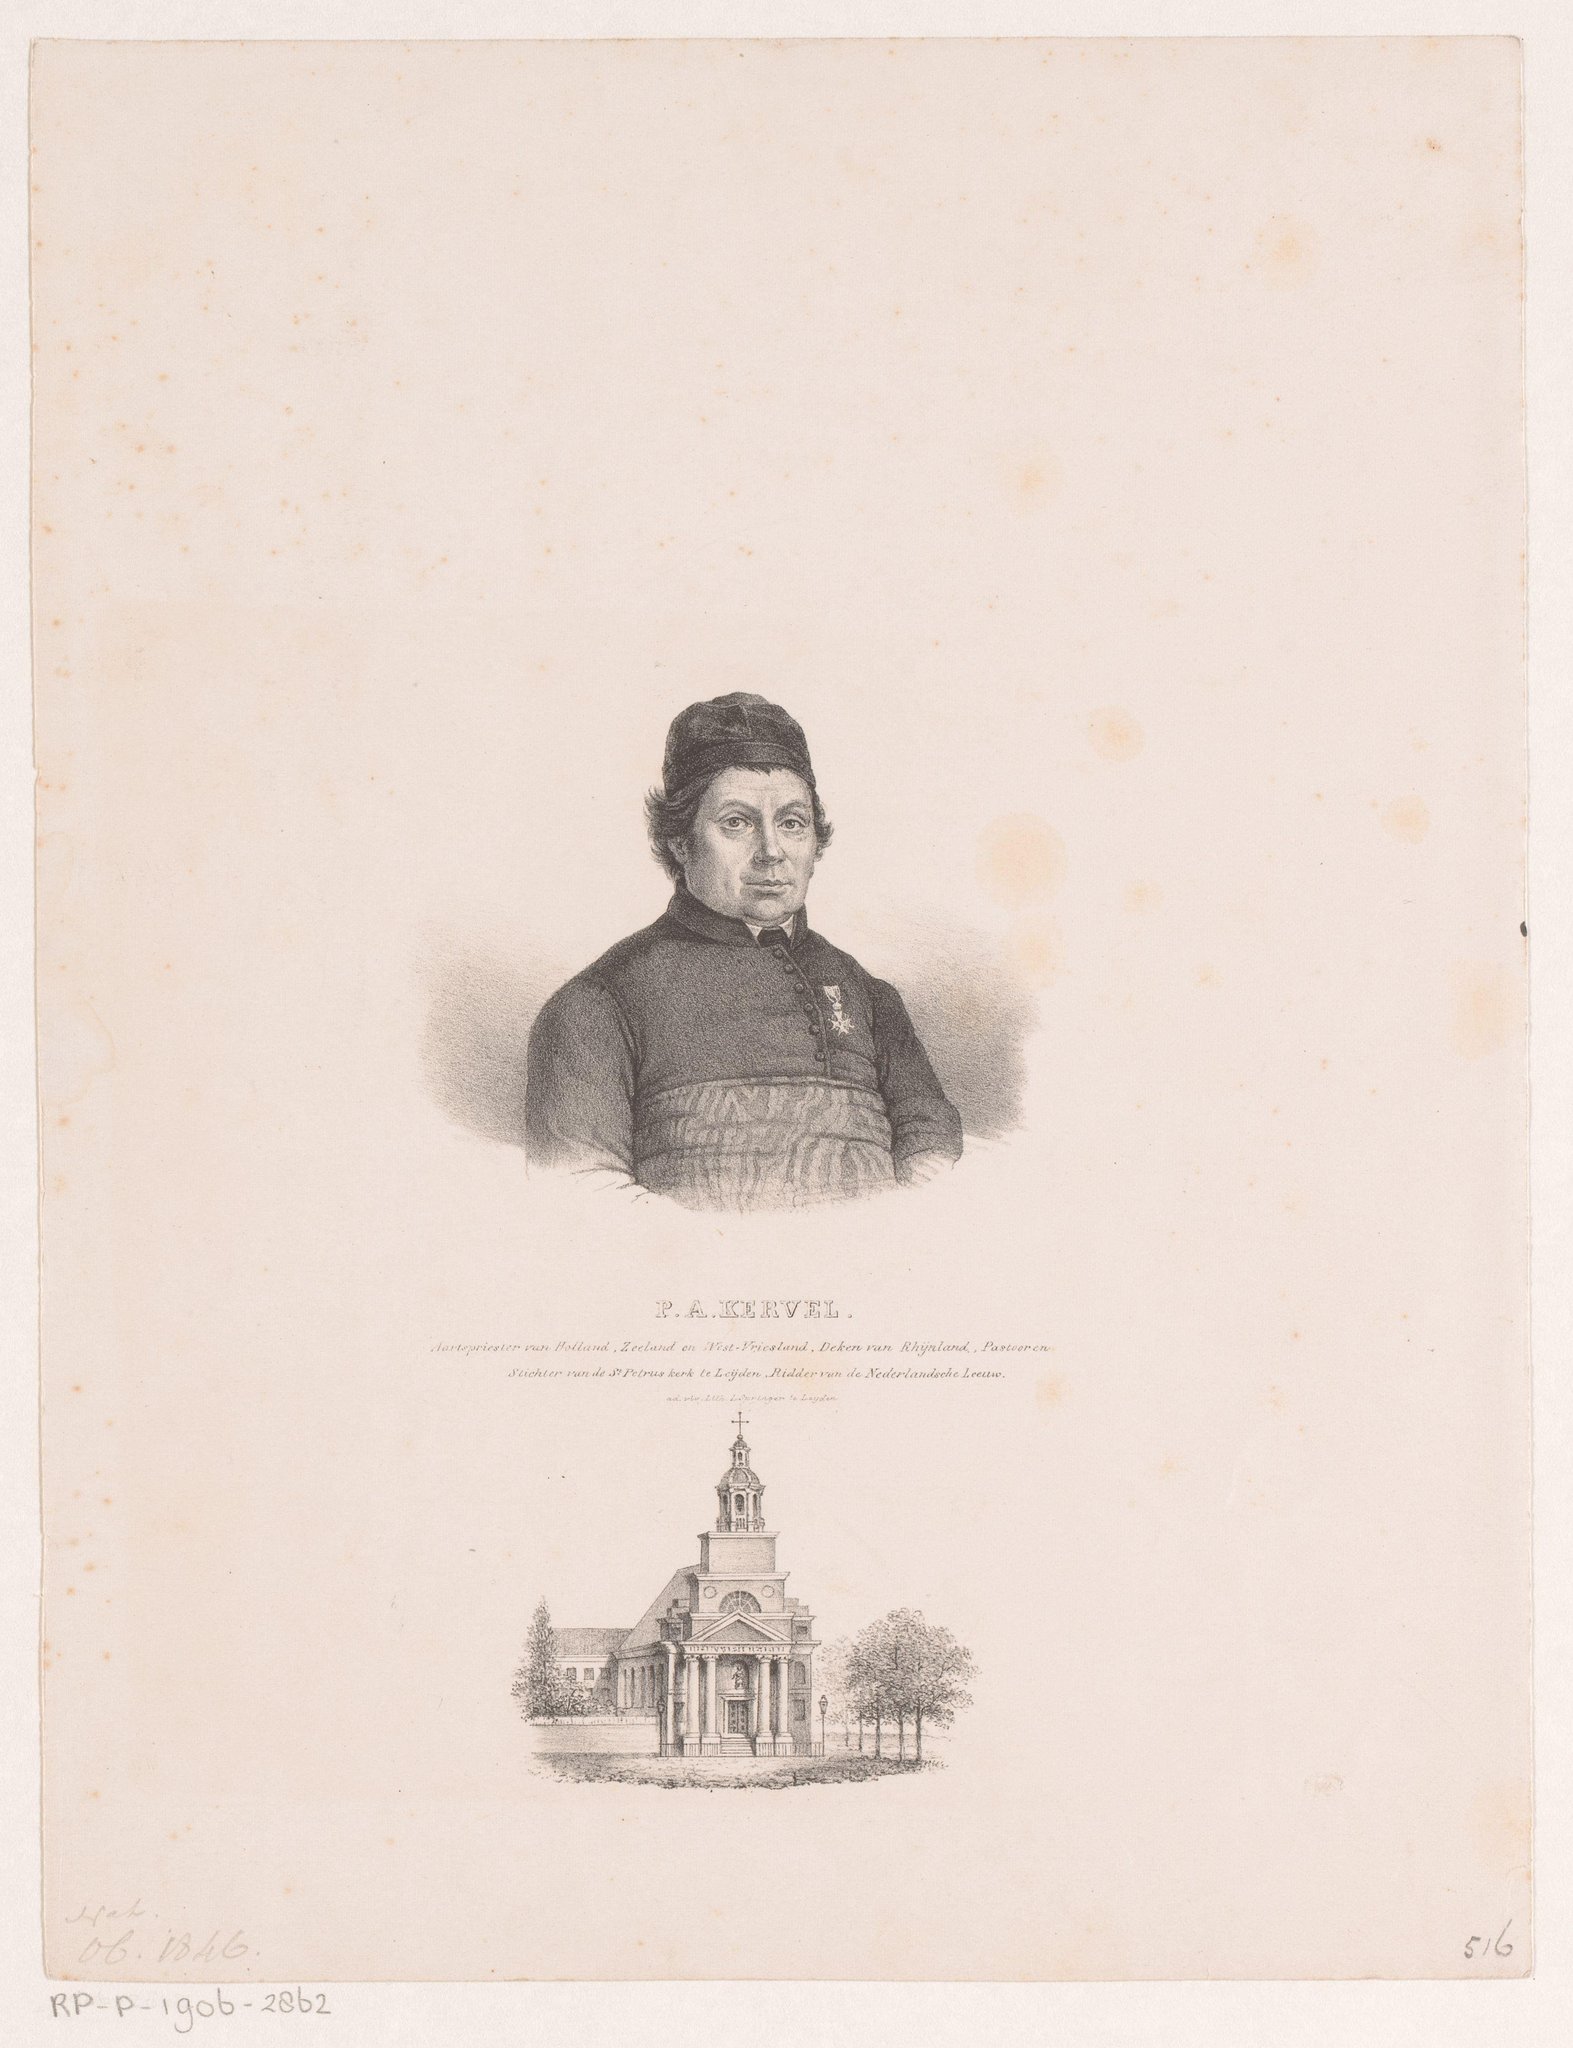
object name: print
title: Portret van Petrus Antonius Kervel en de Sint-Petruskerk te Leiden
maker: leendert springer (i)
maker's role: draughtsman, painter, print maker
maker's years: 1789-1871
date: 1835-1871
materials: paper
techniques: lithograph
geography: leiden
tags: gouda, historical persons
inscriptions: collector's mark: Lugt 2228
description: Onder het portret de biografische gegevens van de geportretteerde en de door hem gestichte en in 1835 gebouwde Sint-Petruskerk.